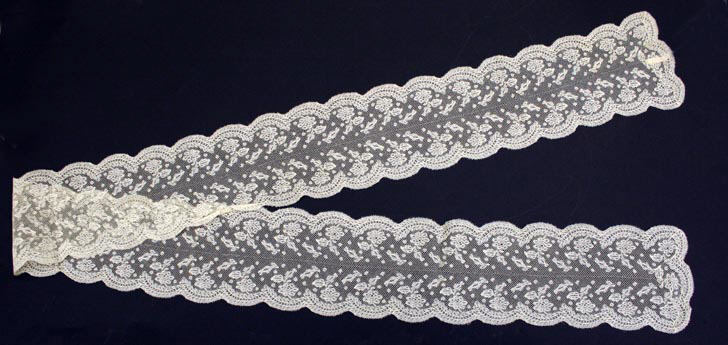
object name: scarf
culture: french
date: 1834-1866